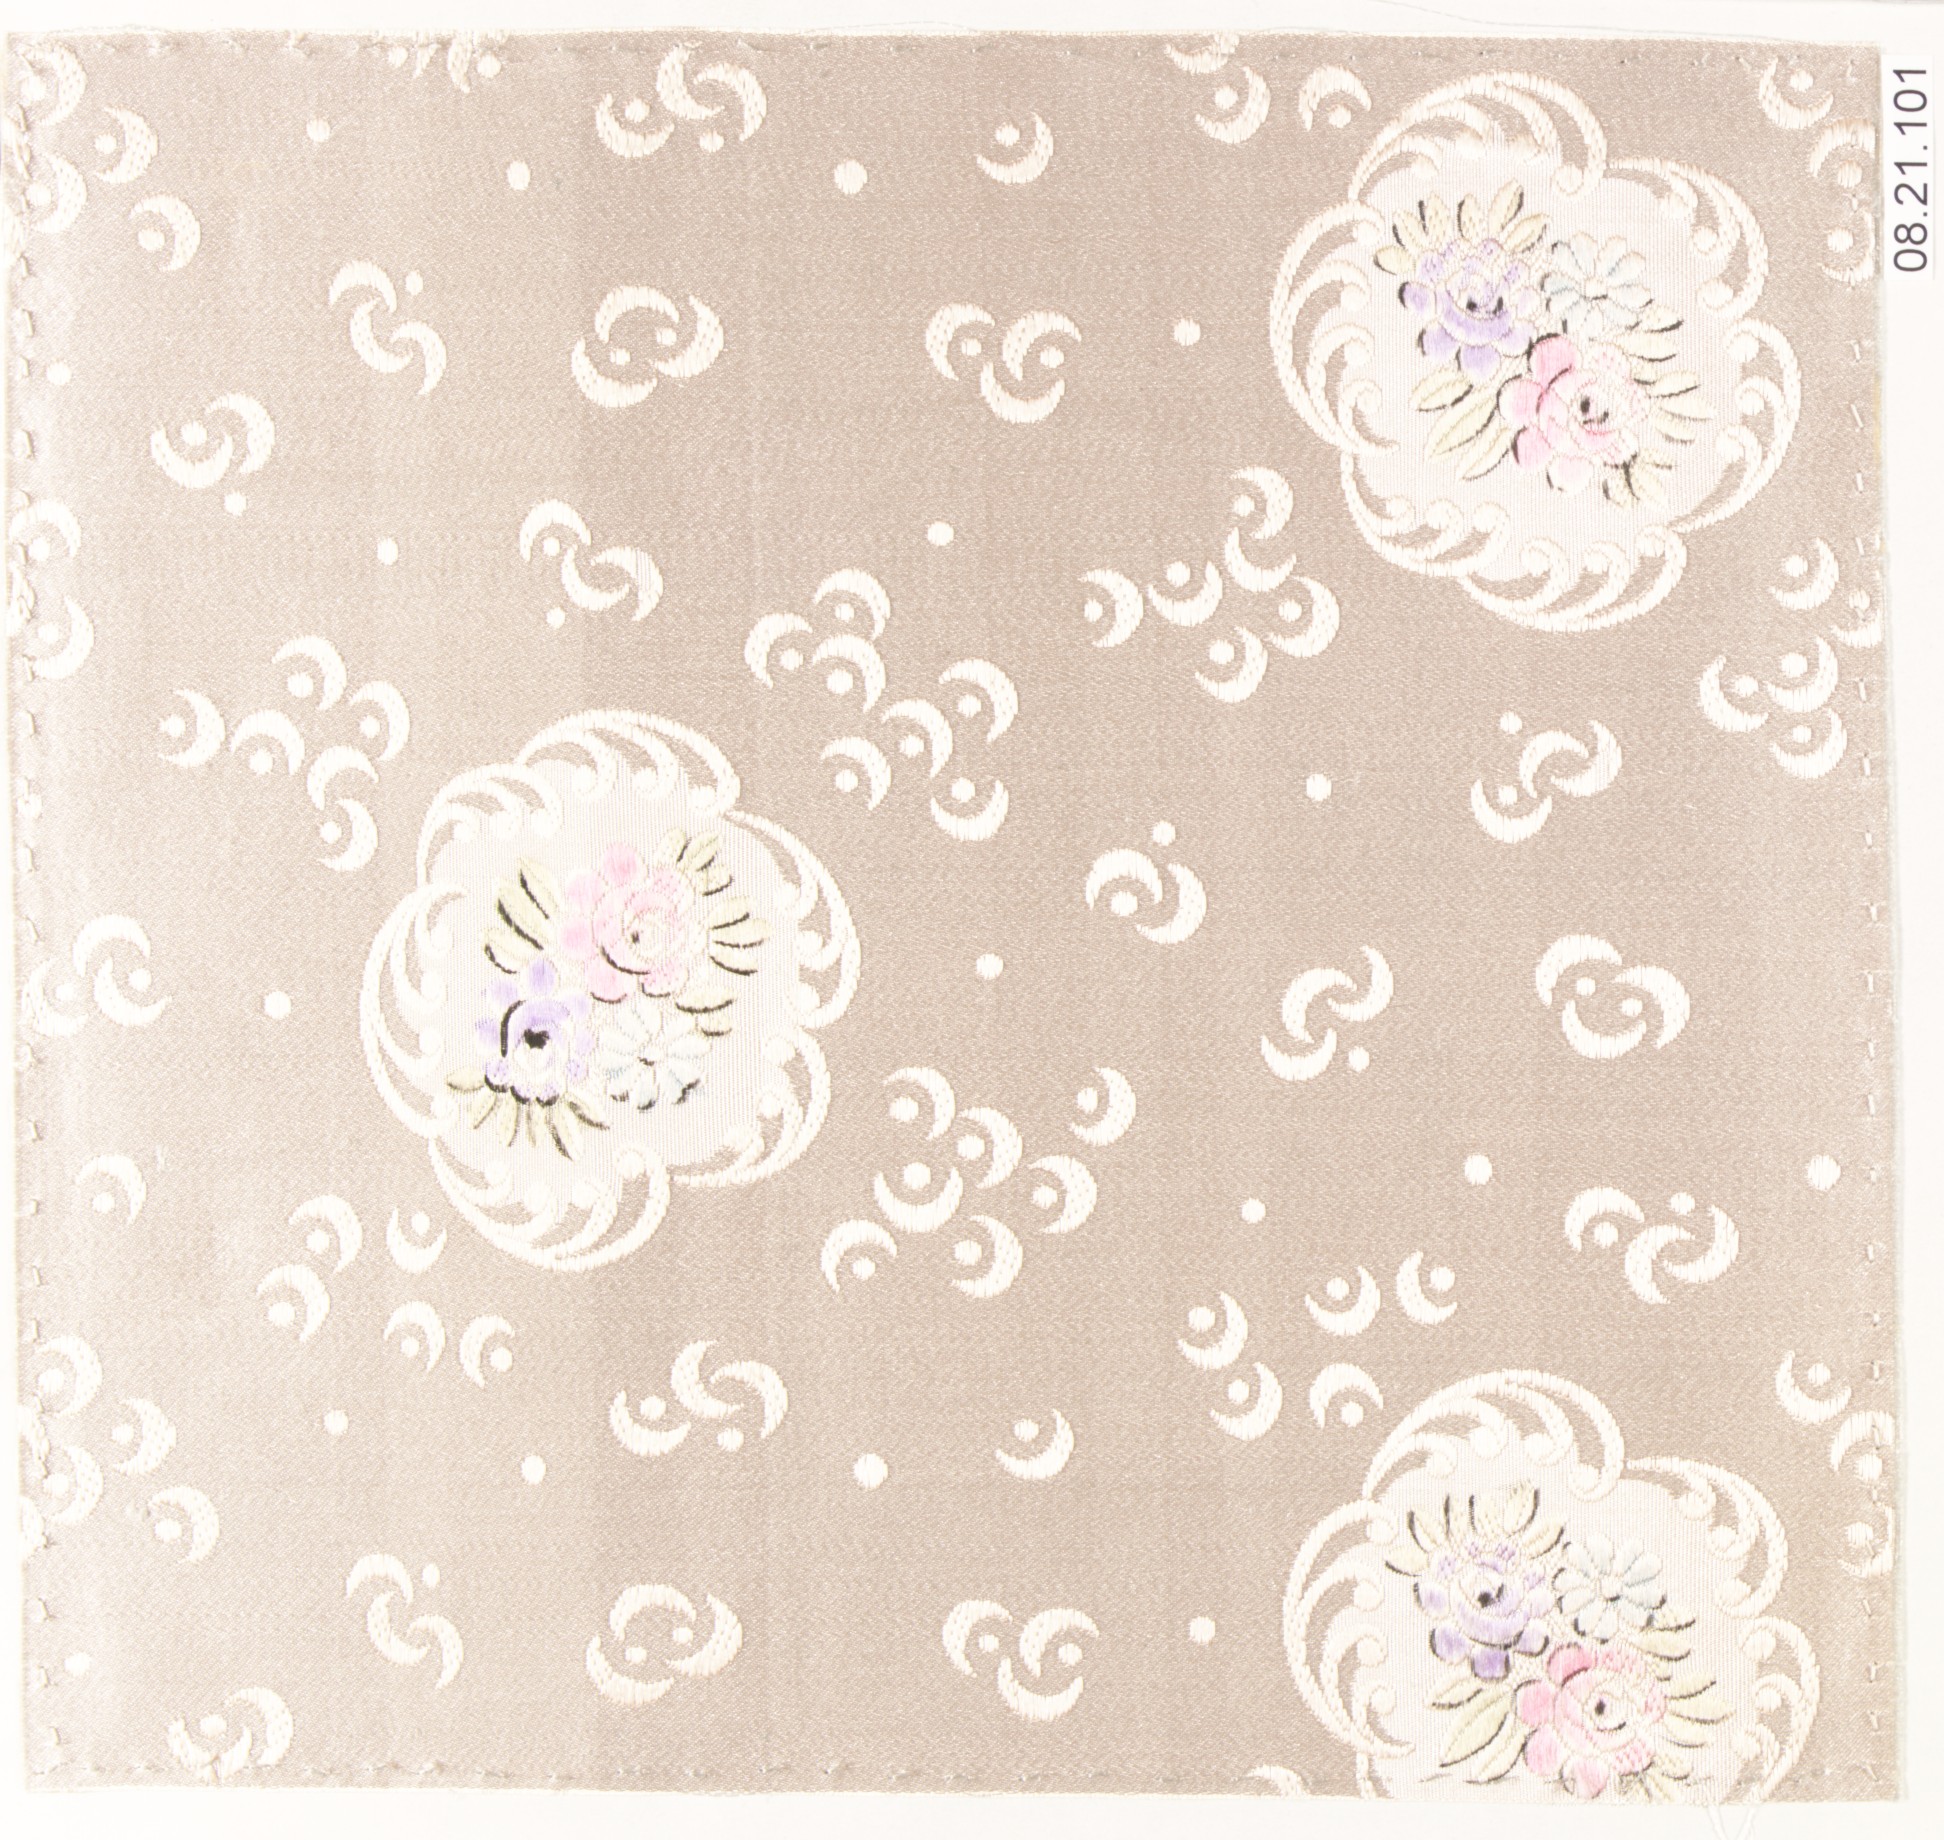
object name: textile sample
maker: Anonymous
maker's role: designer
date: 1900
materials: silk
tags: flowers